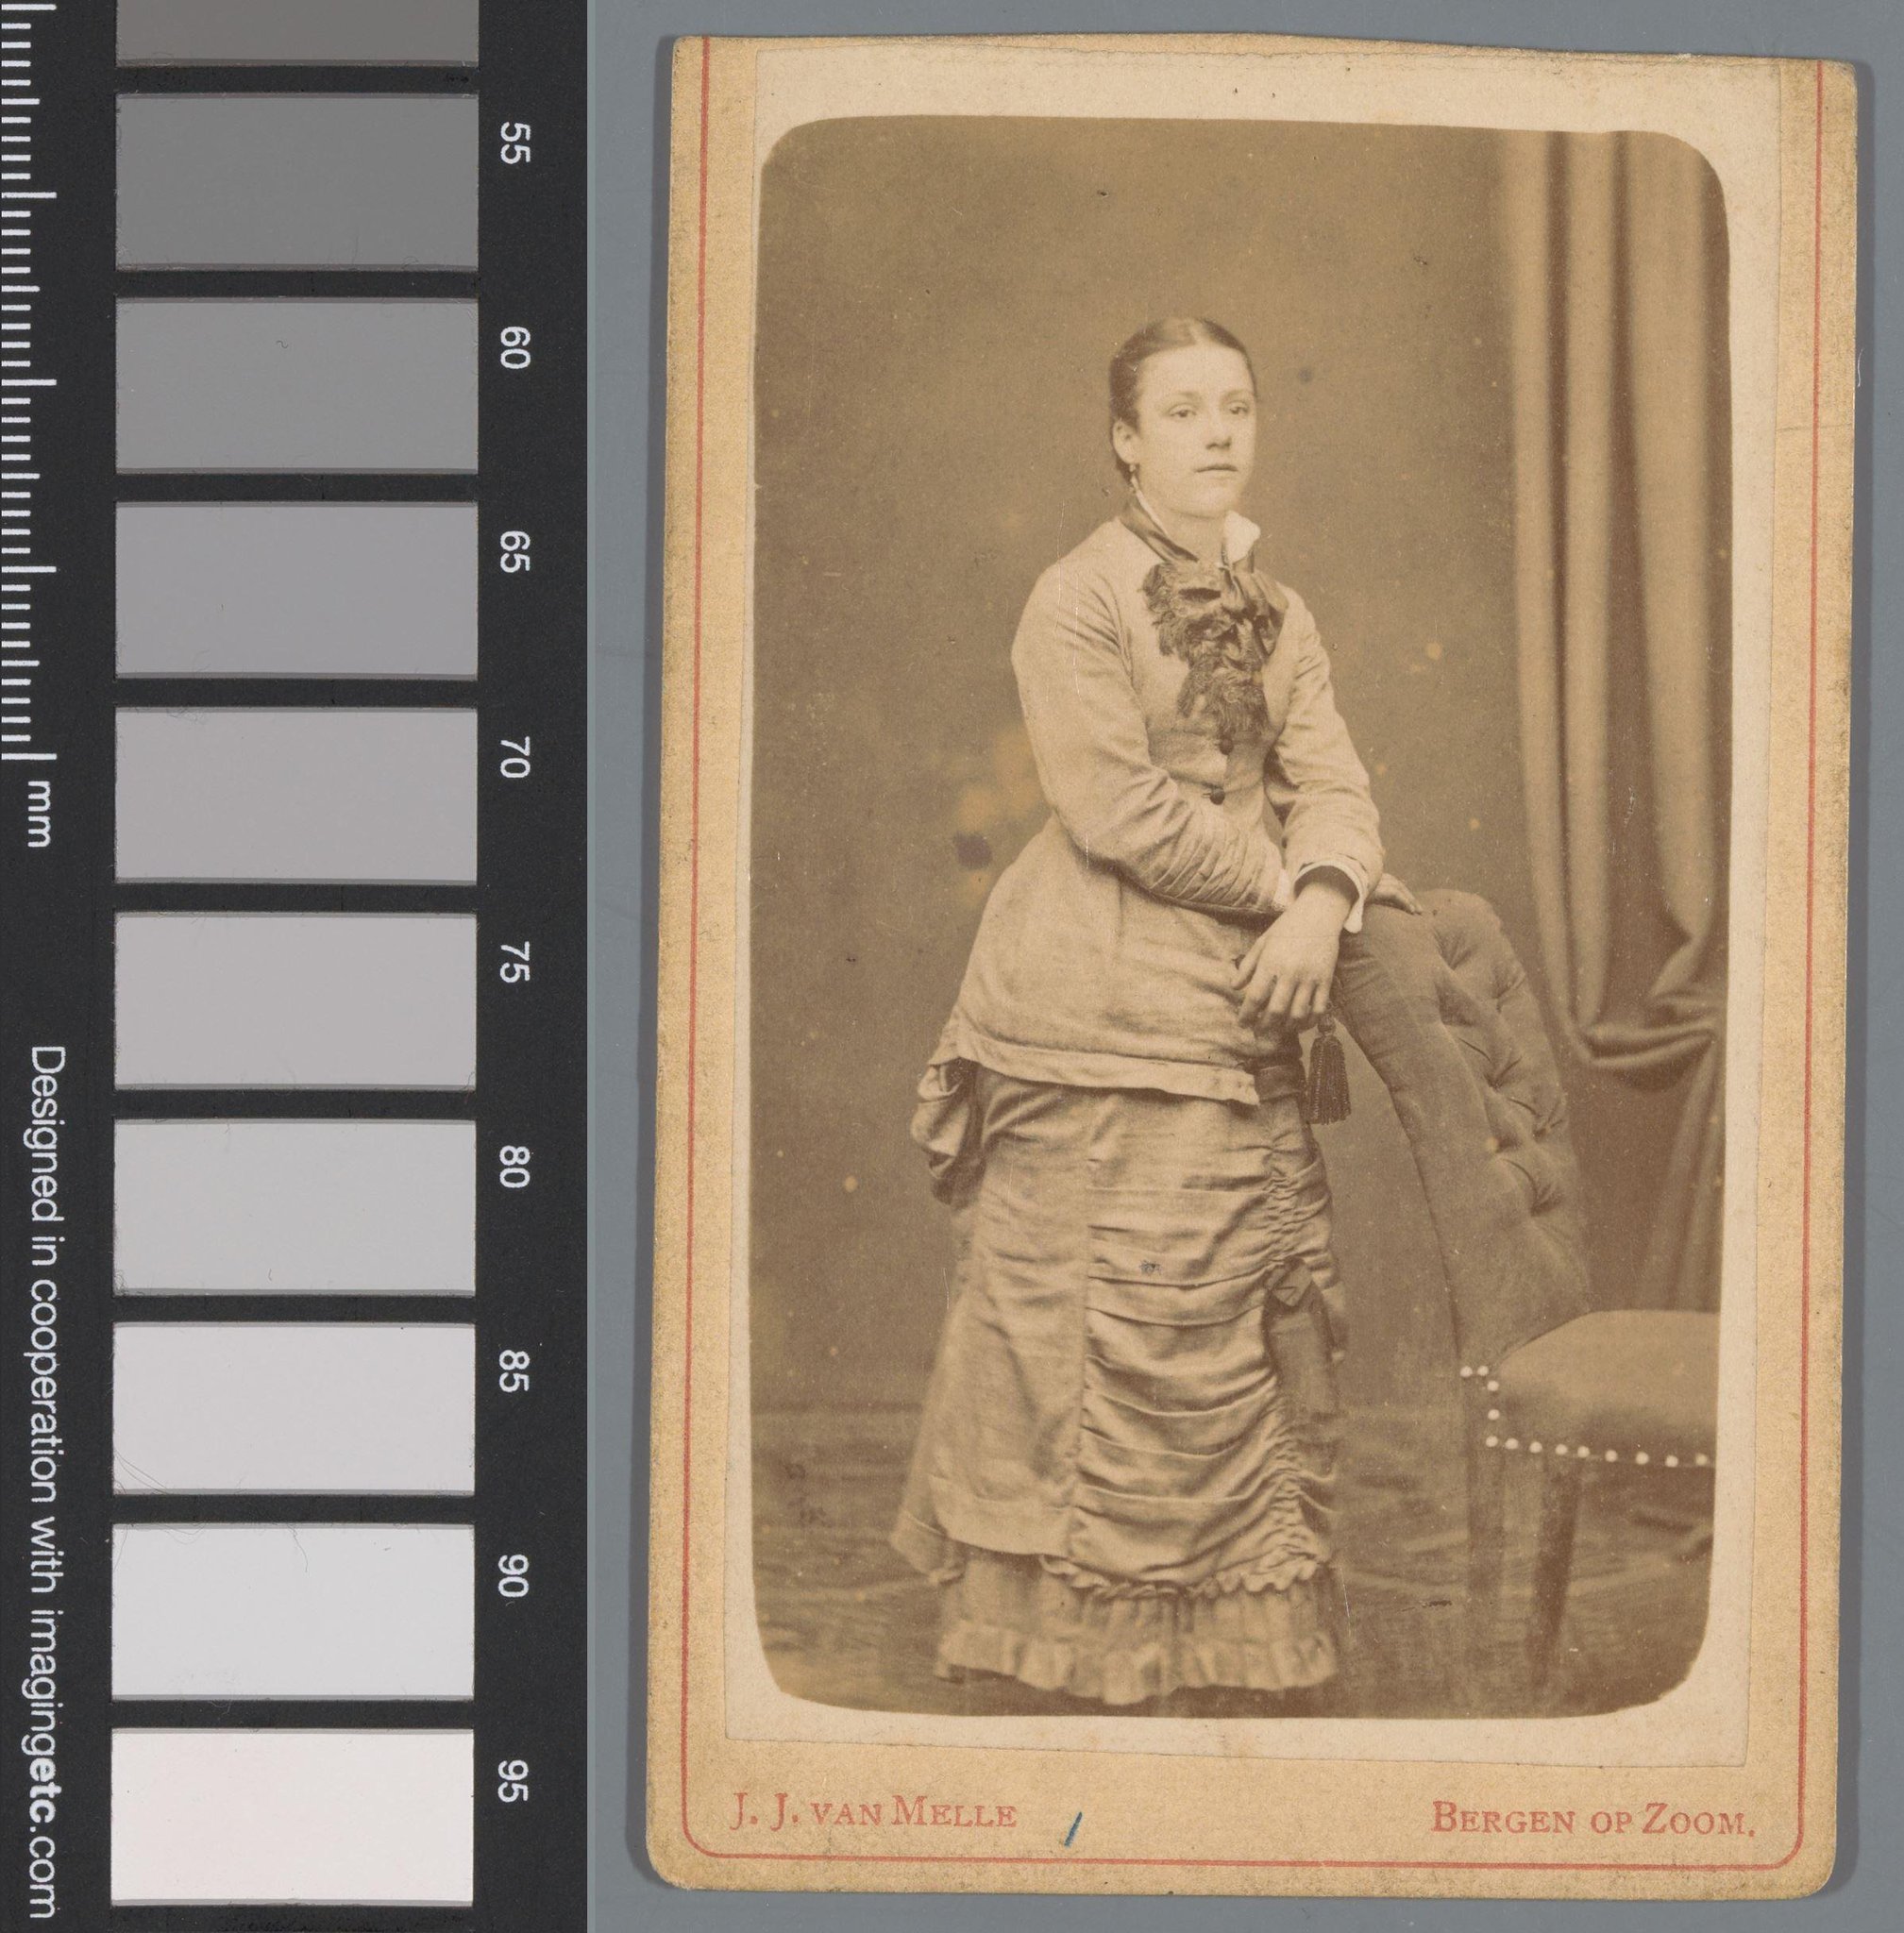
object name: carte de visite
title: Portret van een onbekende jonge vrouw achter een stoel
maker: jannis jacobus van melle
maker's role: fotograaf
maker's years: 1829-1911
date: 1877-1885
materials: cardboard, paper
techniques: albumen print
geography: bergen op zoom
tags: adolescent, young woman, maiden, anonymous historical person portrayed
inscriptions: inscription: ‘De plaat blijft tot nabestelling bewaard./ Van jeder portret kunnen vergrootingen/ geleverd worden.’, address: ‘Bergen op Zoom/ Rijke Buurtstraat.’